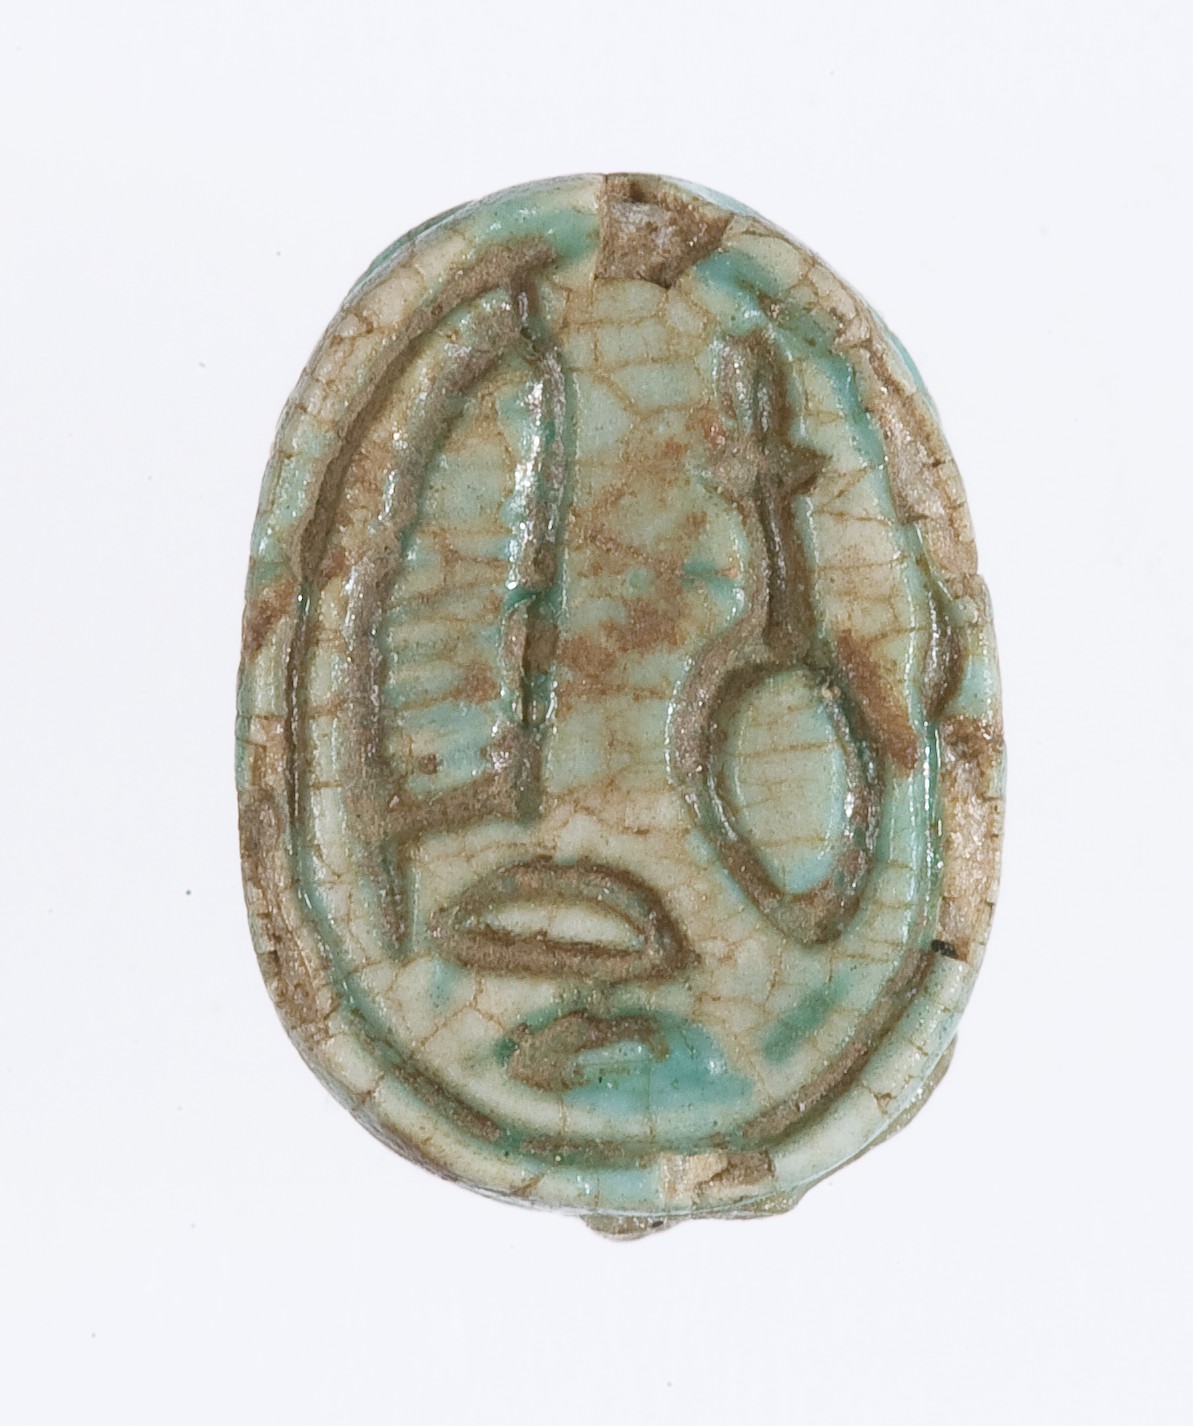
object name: scarab, nefertari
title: Scarab Inscribed With the Name Nefertari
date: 1550-1525 BCE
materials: stone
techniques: glazing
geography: egypt